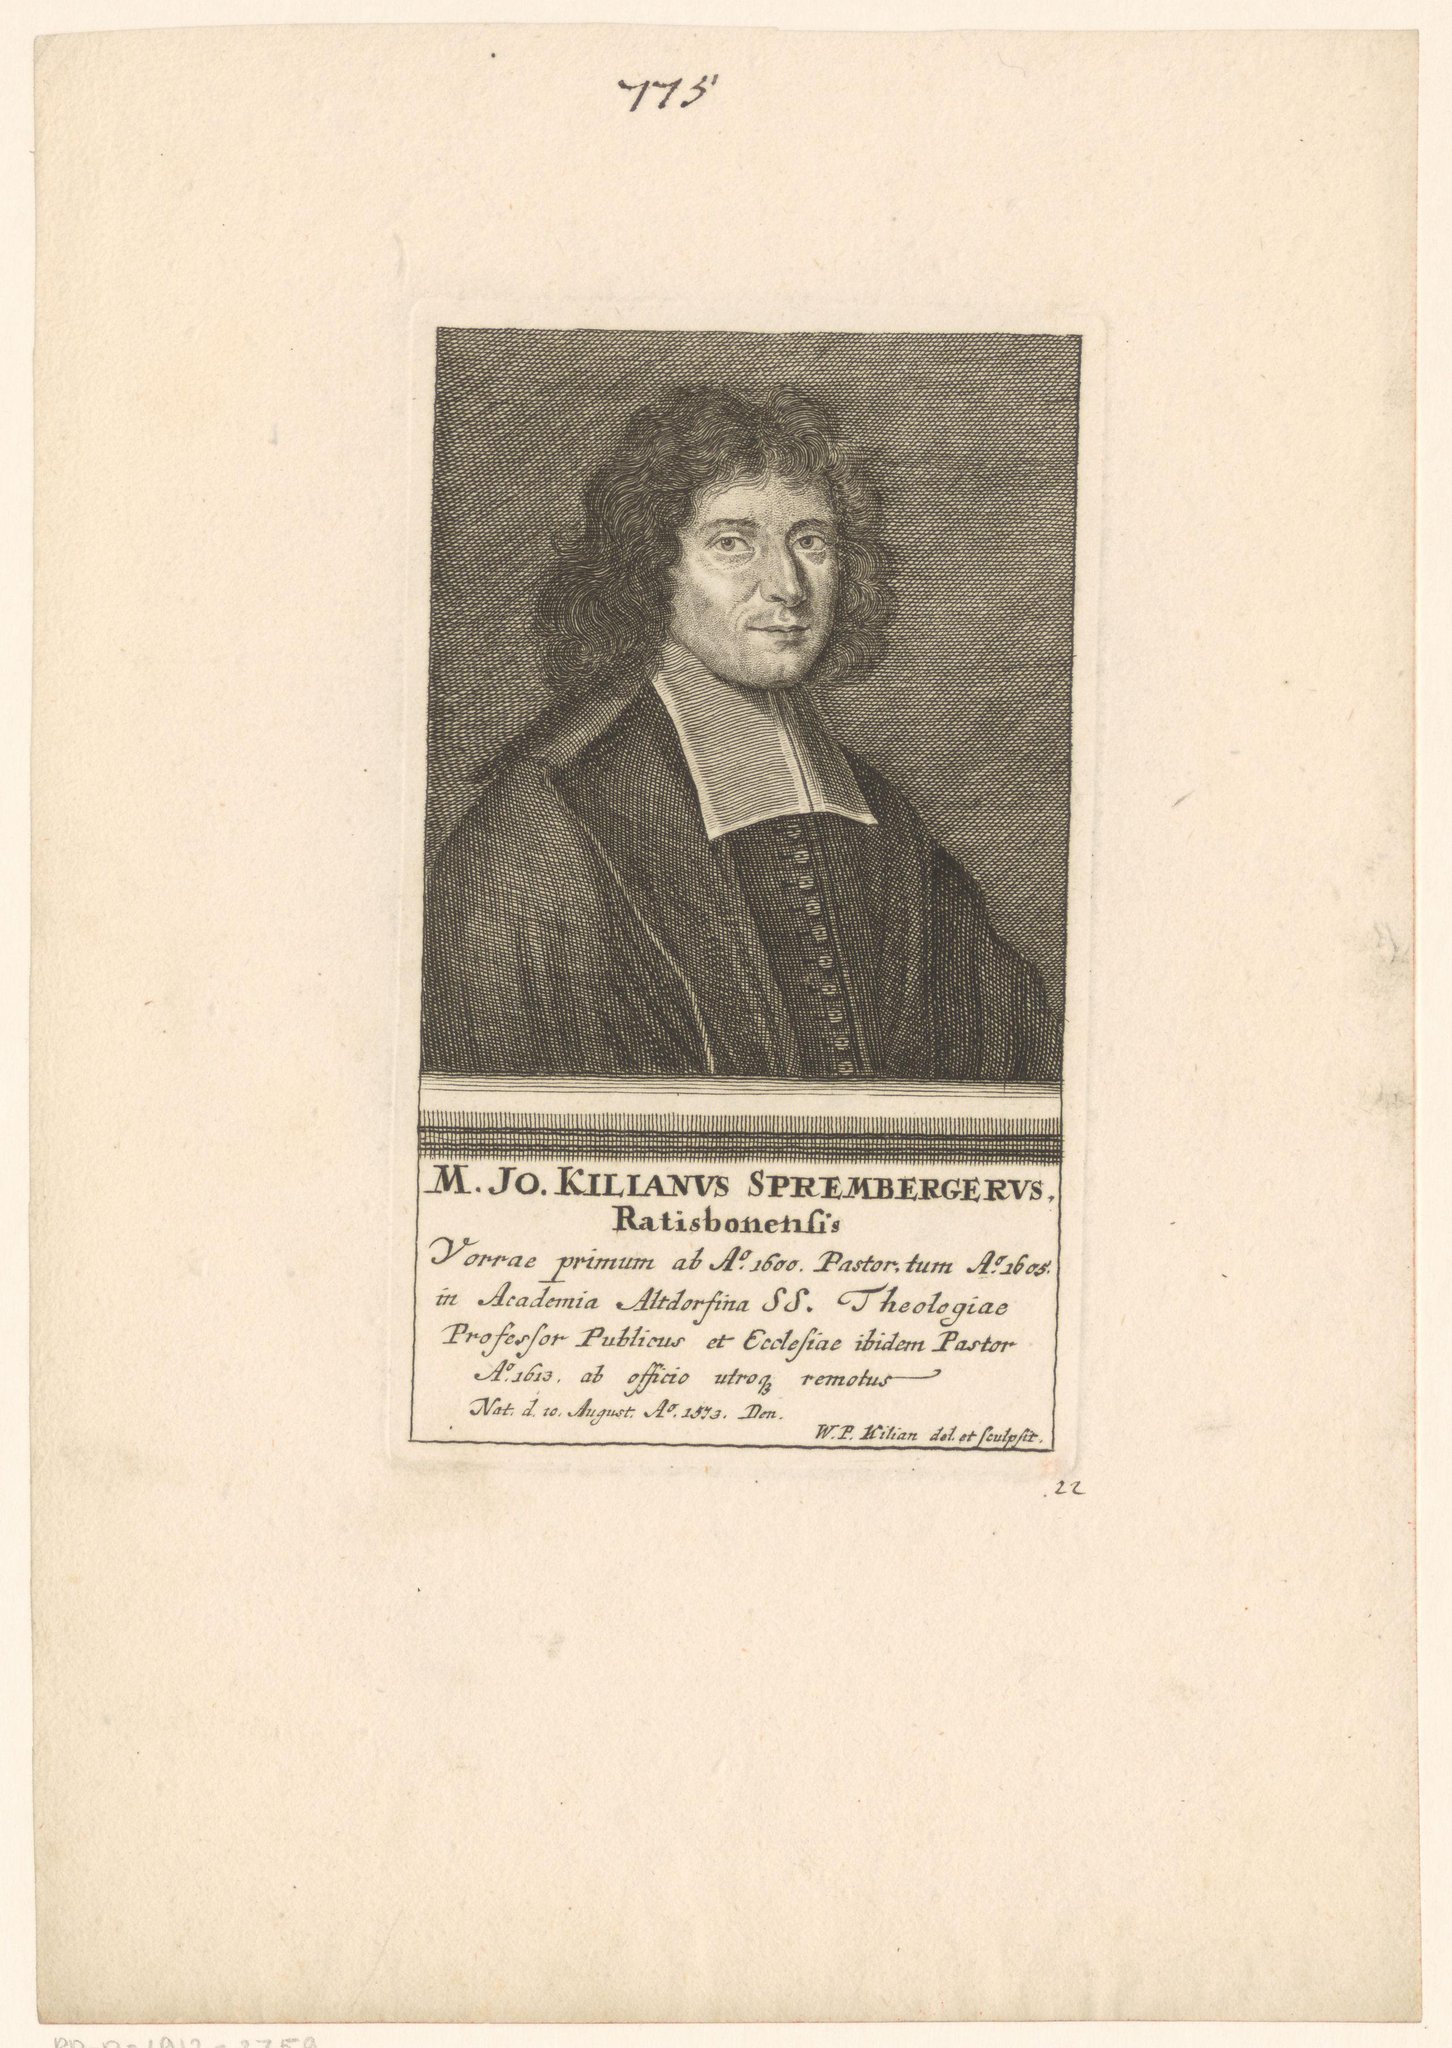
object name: print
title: Portret van Johann Kilian Spremberger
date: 1669-1722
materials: paper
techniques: engraving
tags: theologian, historical persons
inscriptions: number: ‘22’, collector's mark: Lugt 2228